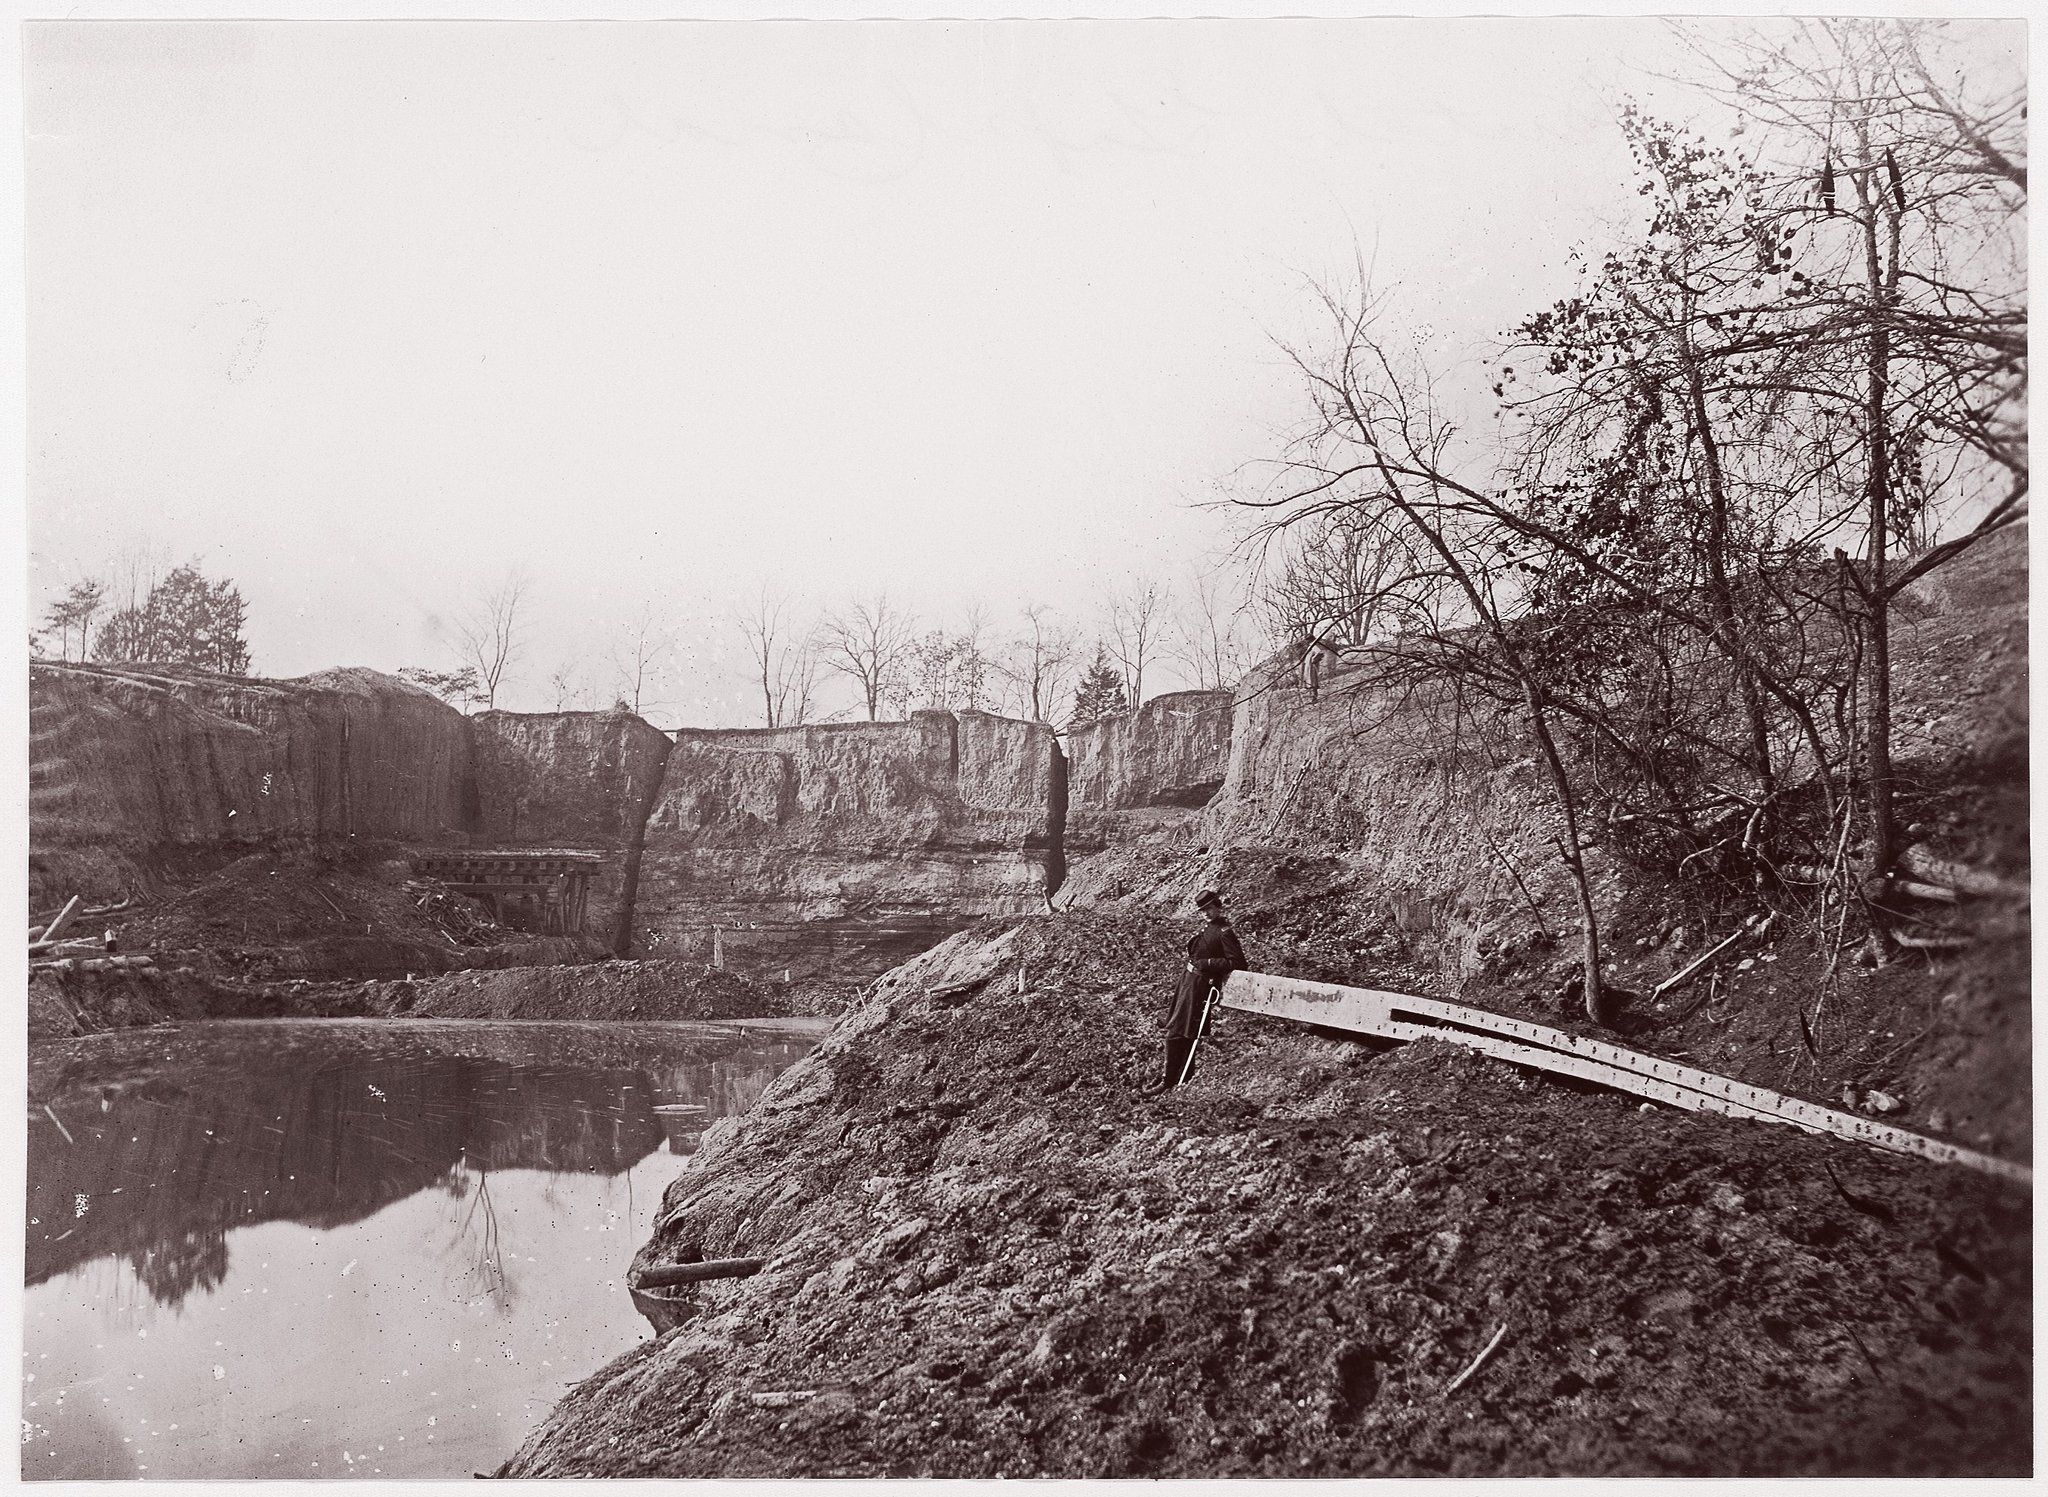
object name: photograph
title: [Dutch Gap Canal, James River, Virginia]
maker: andrew joseph russell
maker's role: artist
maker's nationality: american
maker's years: 1830-1902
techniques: albumen silver print, glass negative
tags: american civil war,canals